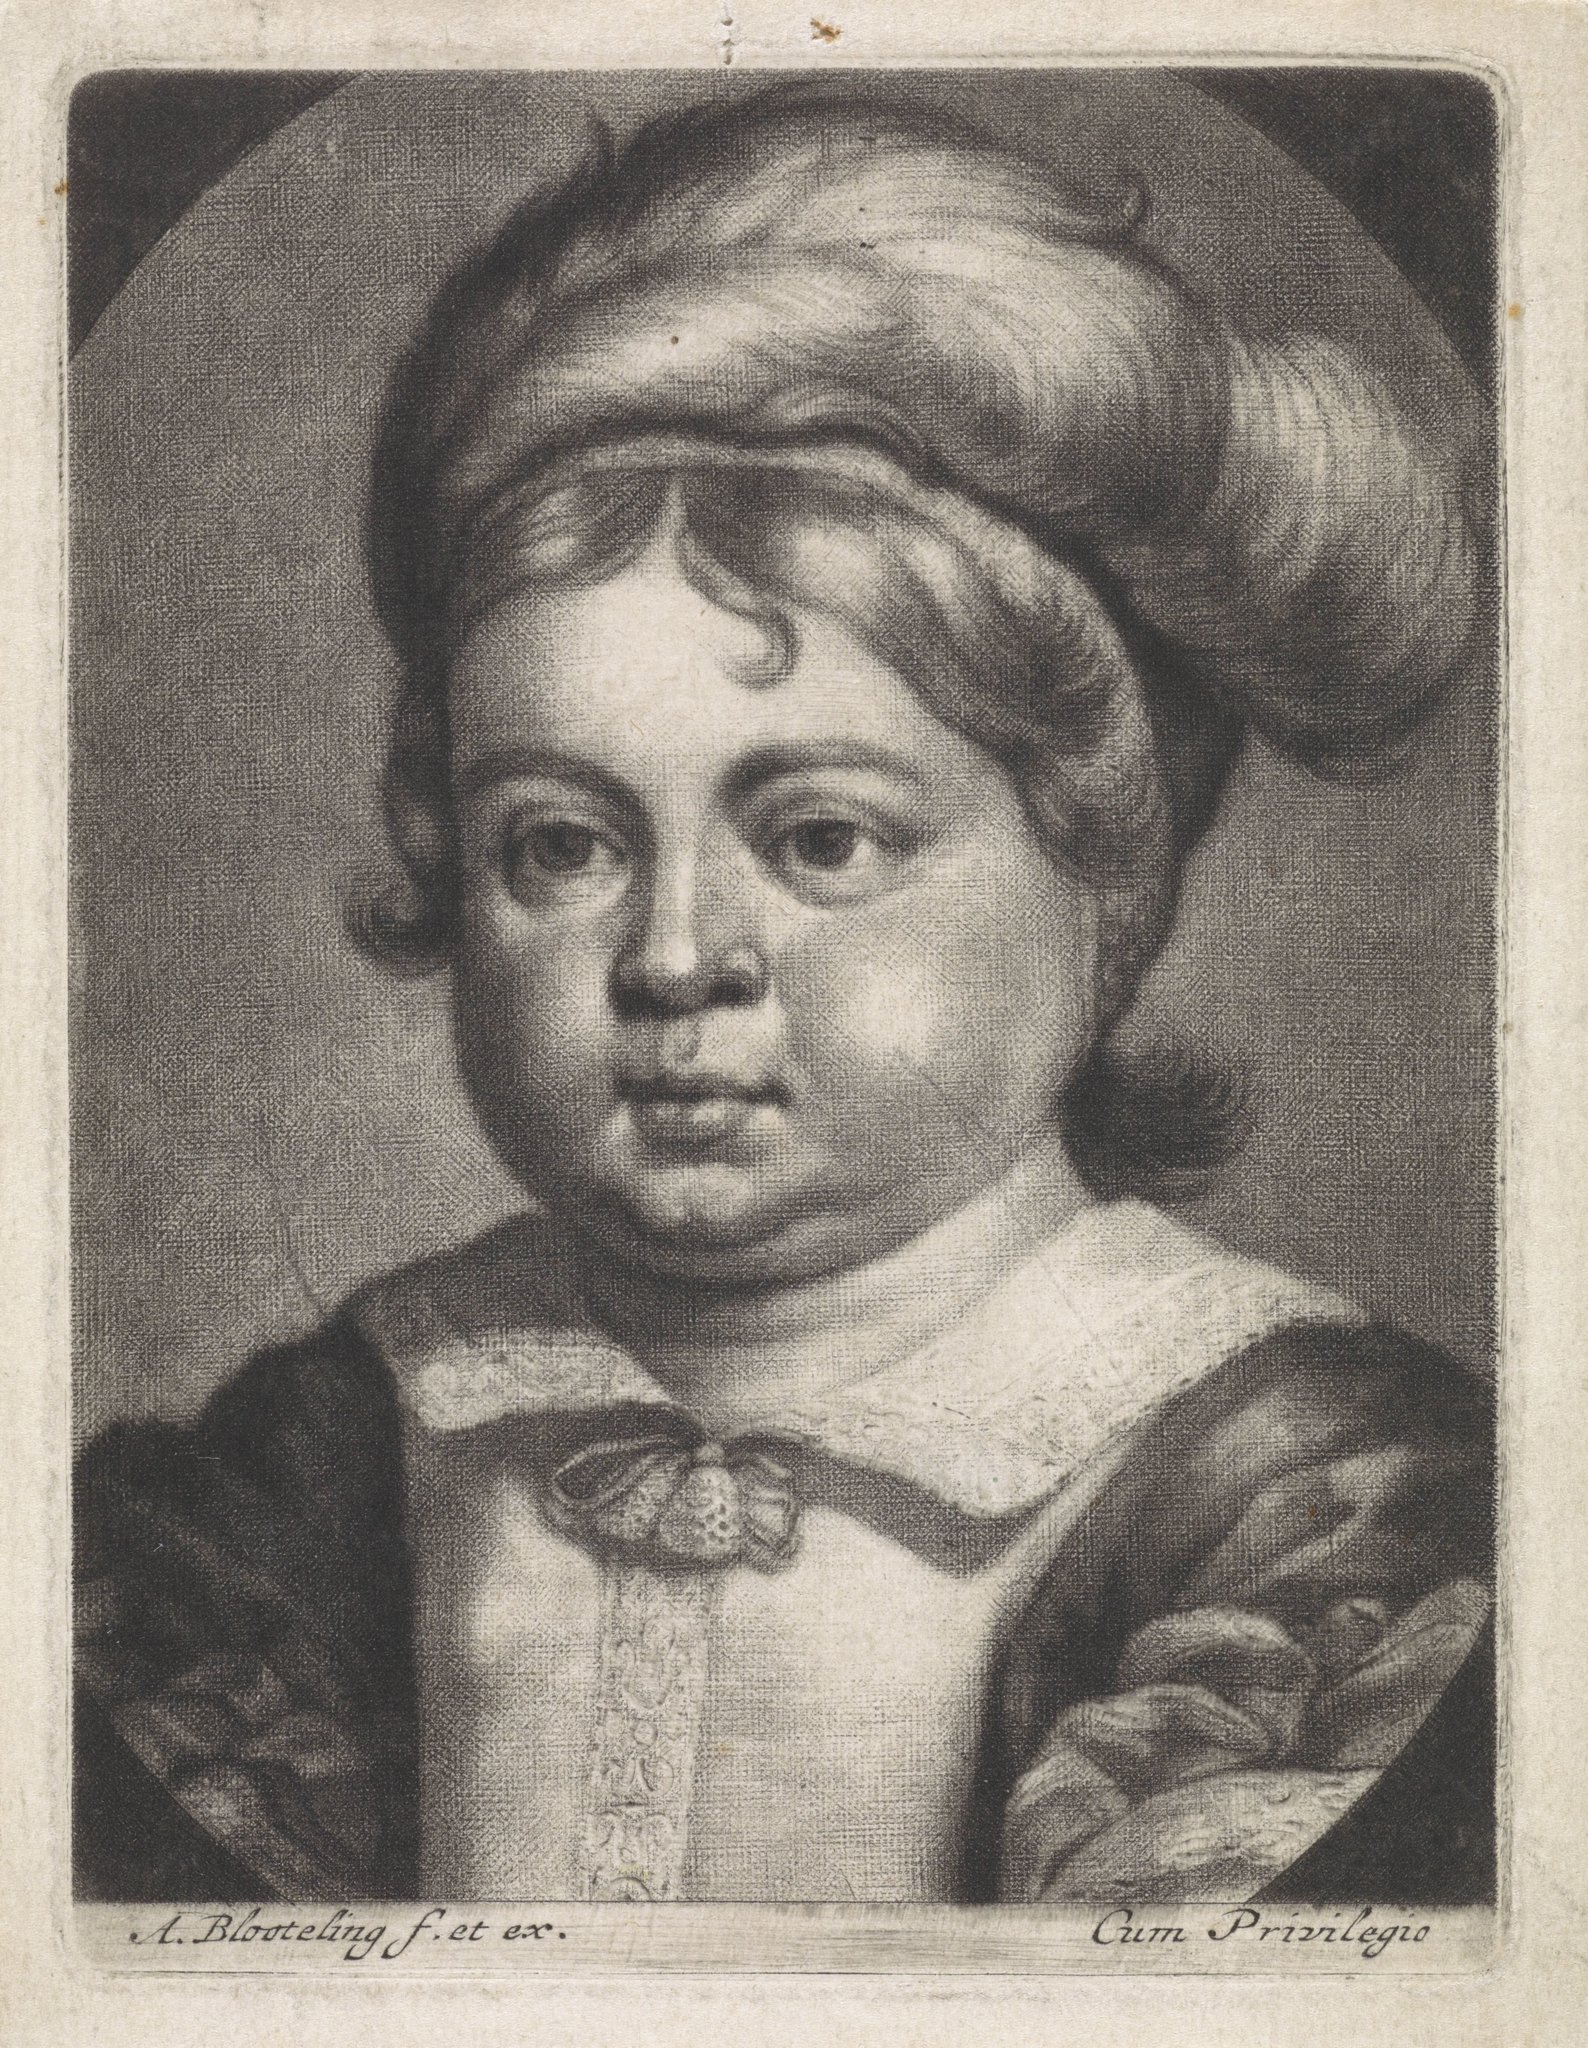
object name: print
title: Buste van een kind met een baret met veren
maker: abraham bloteling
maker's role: draughtsman, print maker, publisher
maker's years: 1640-1690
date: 1652-1690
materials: paper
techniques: mezzotint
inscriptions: collector's mark: Lugt 2228